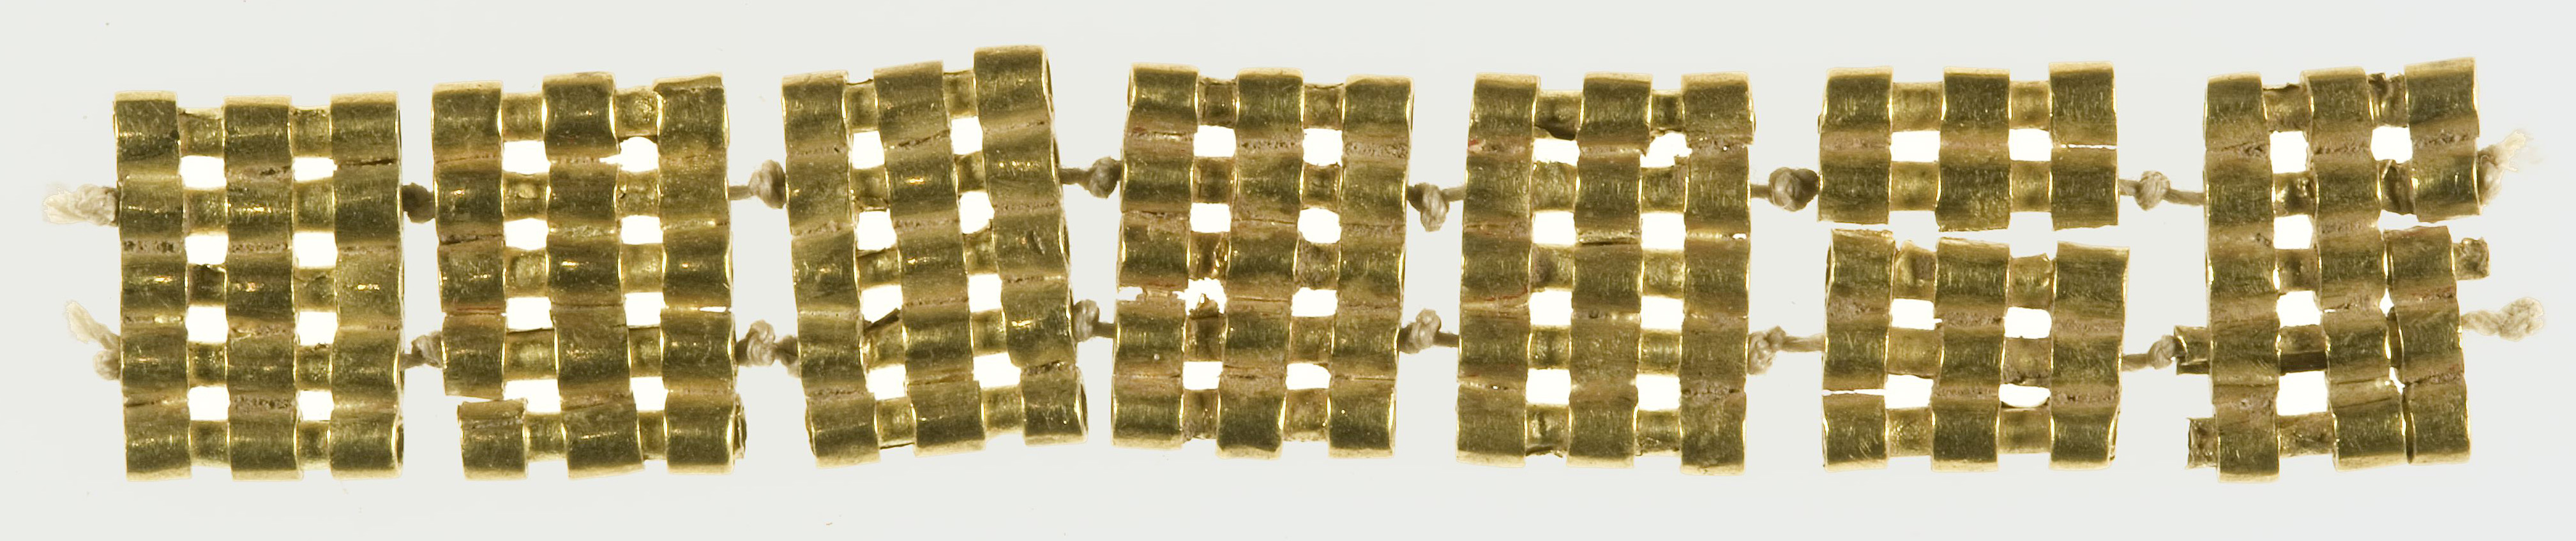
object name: spacer, sithathoryunet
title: Spacers from the Jewelry of Sithathoryunet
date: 1887-1813 BCE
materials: gold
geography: egypt